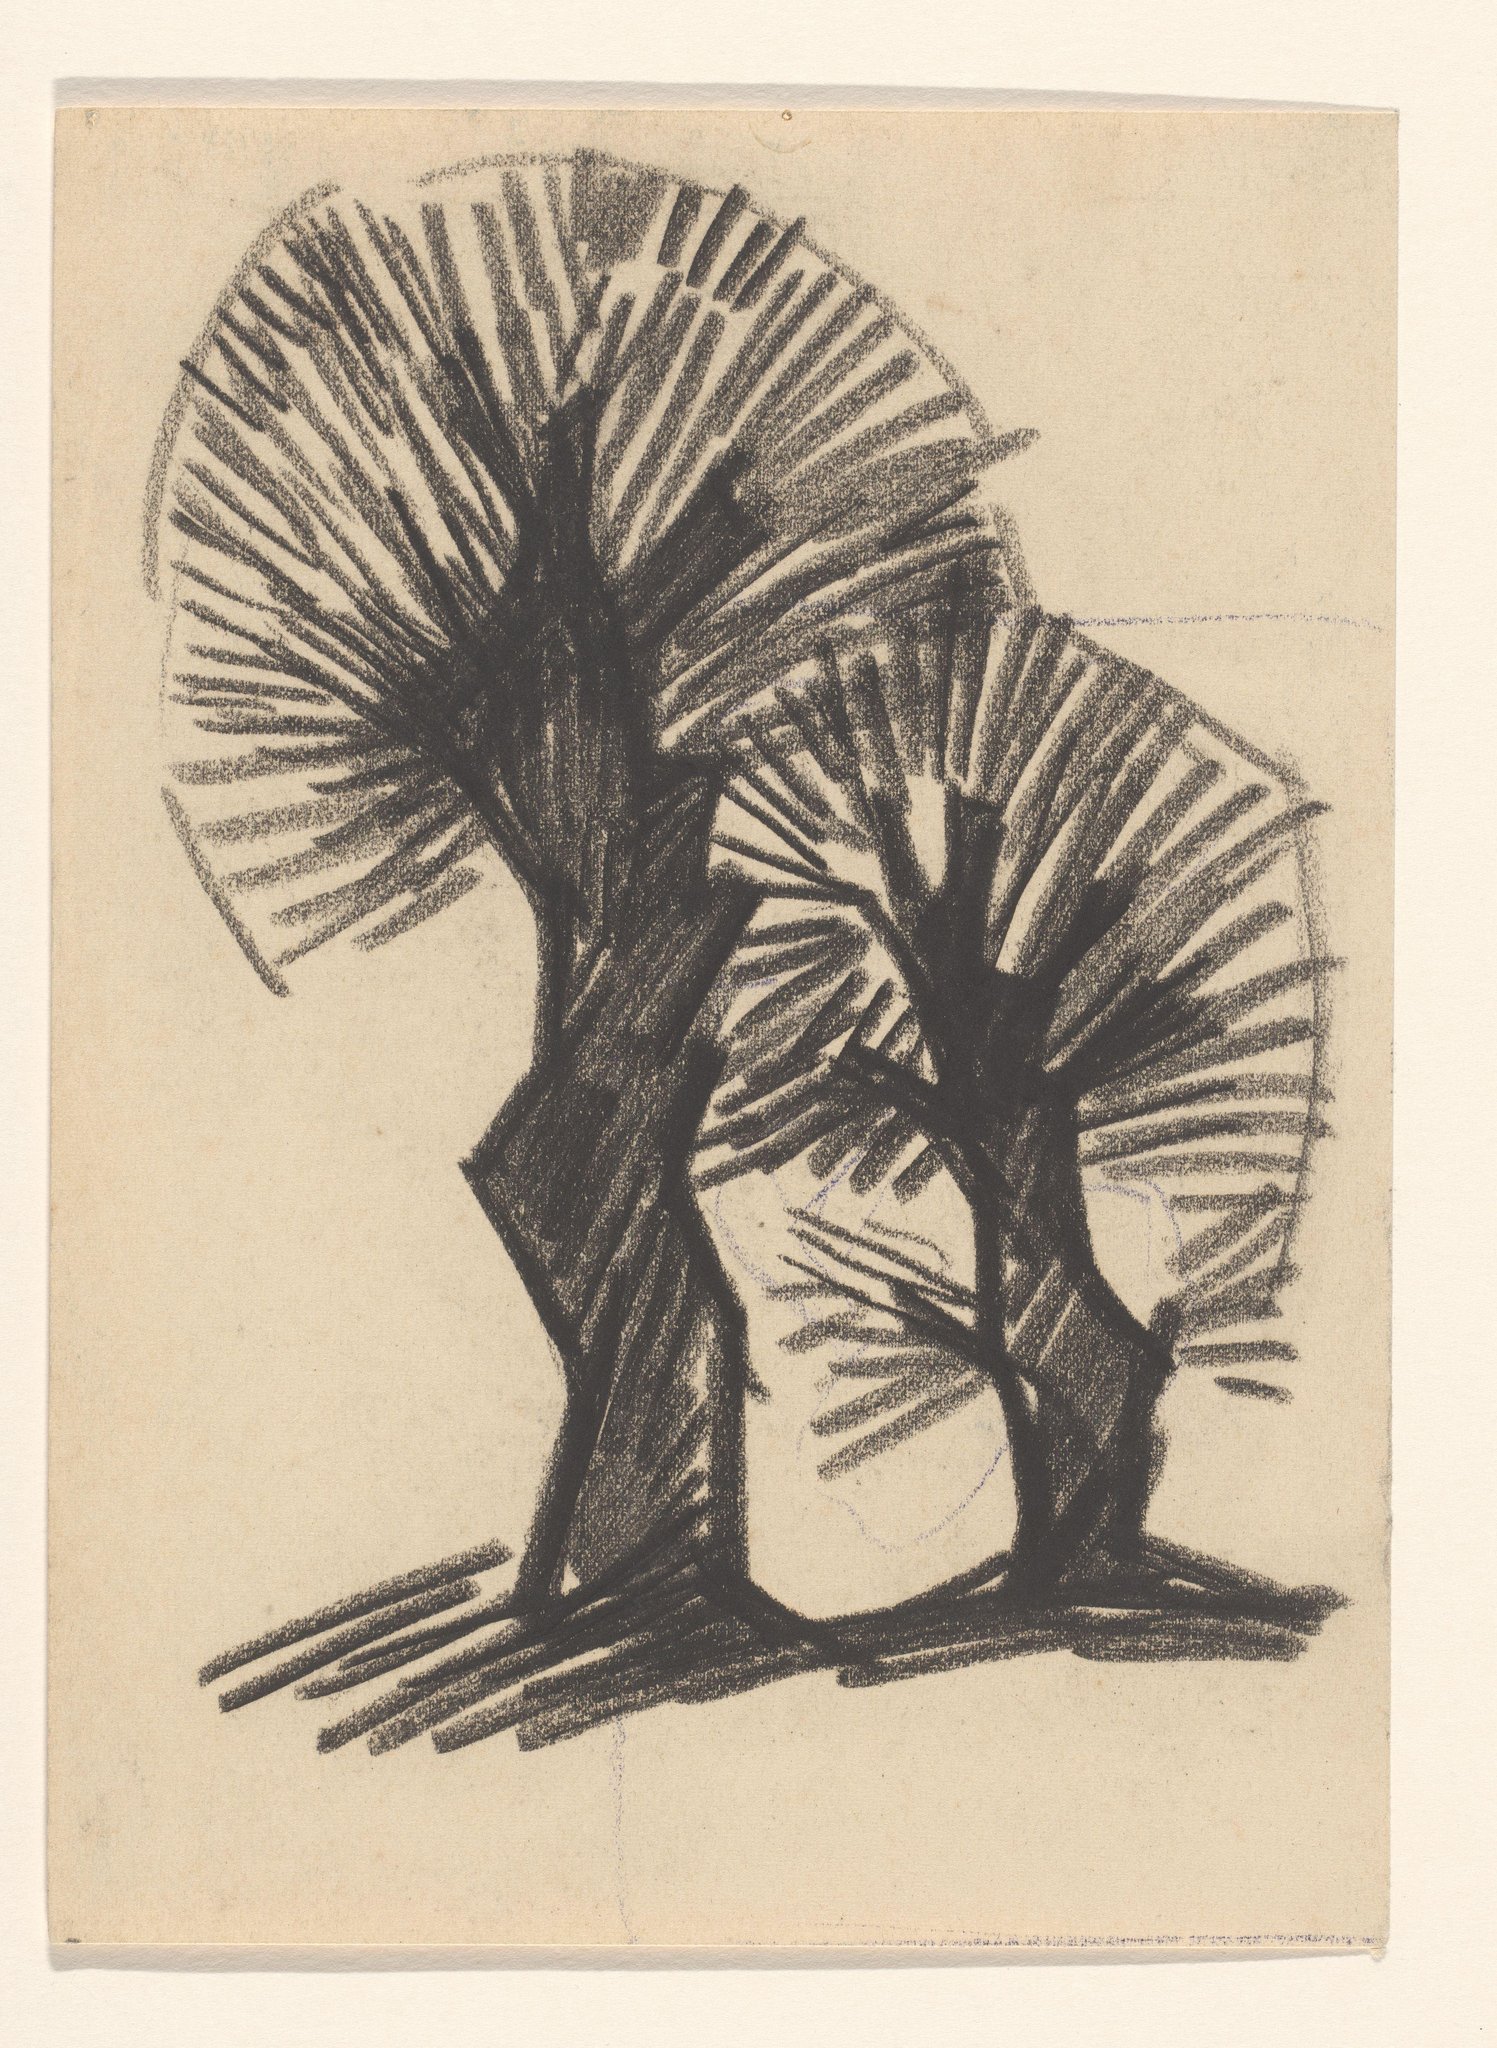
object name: drawing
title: Twee bomen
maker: julie de graag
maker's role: draughtsman, print maker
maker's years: 1877-1924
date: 1887-1924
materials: chalk, paper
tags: trees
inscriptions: number: ‘8’, number: ‘32’